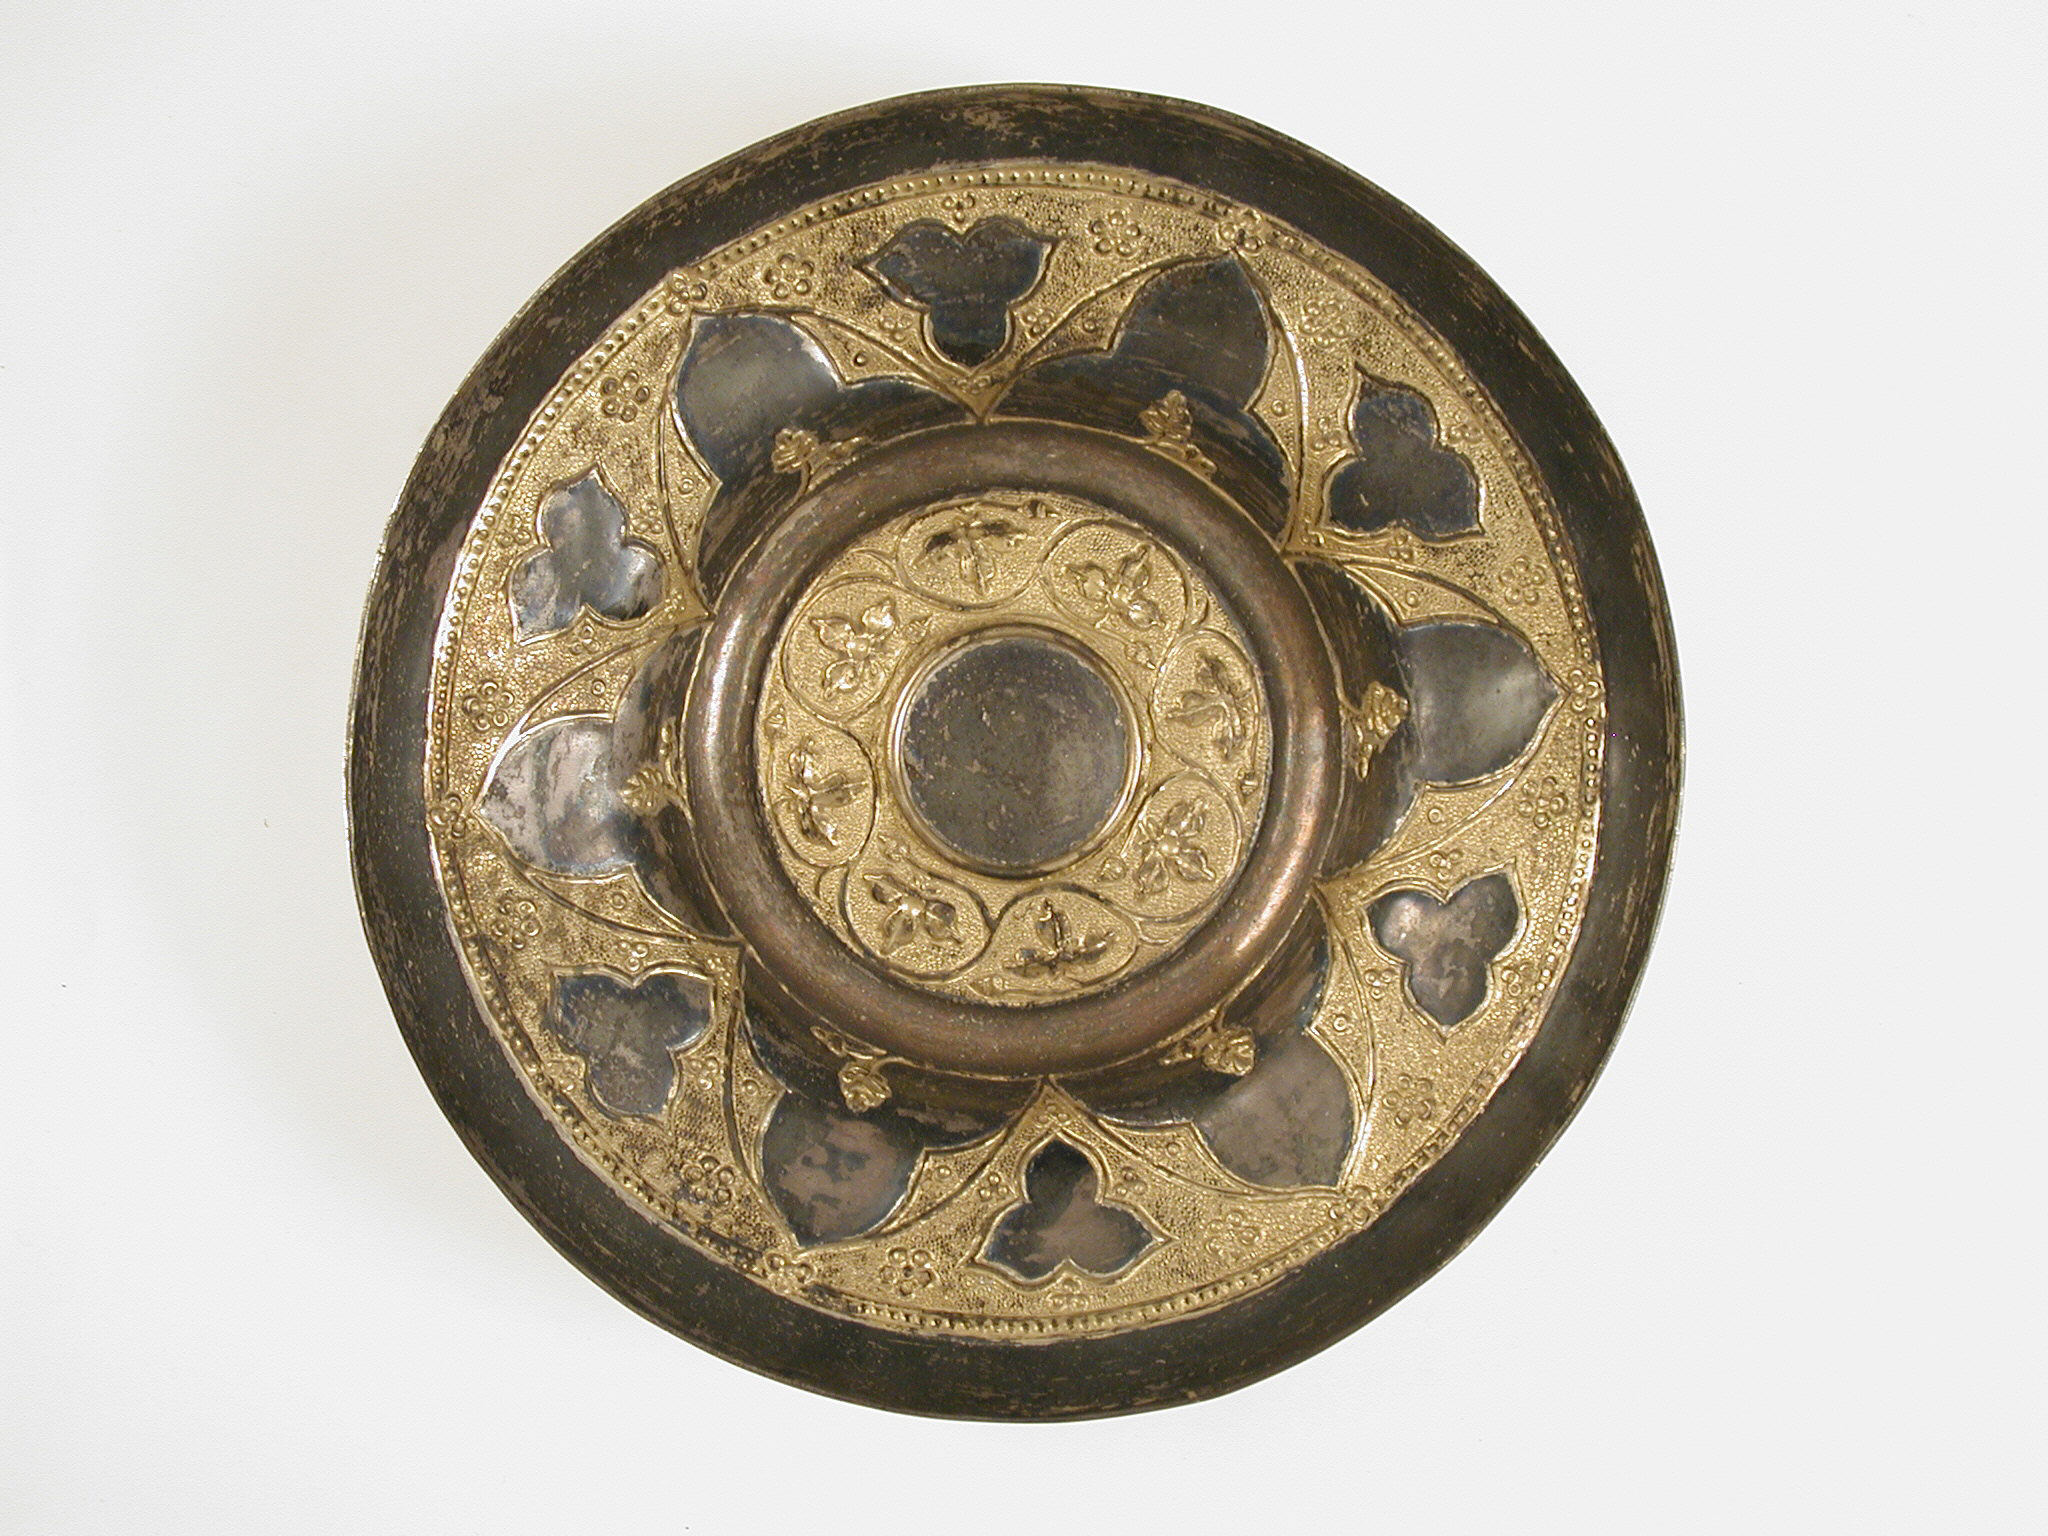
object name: bowl or plate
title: Bowl or Deep Plate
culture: french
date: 1801-1900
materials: gilt, silver